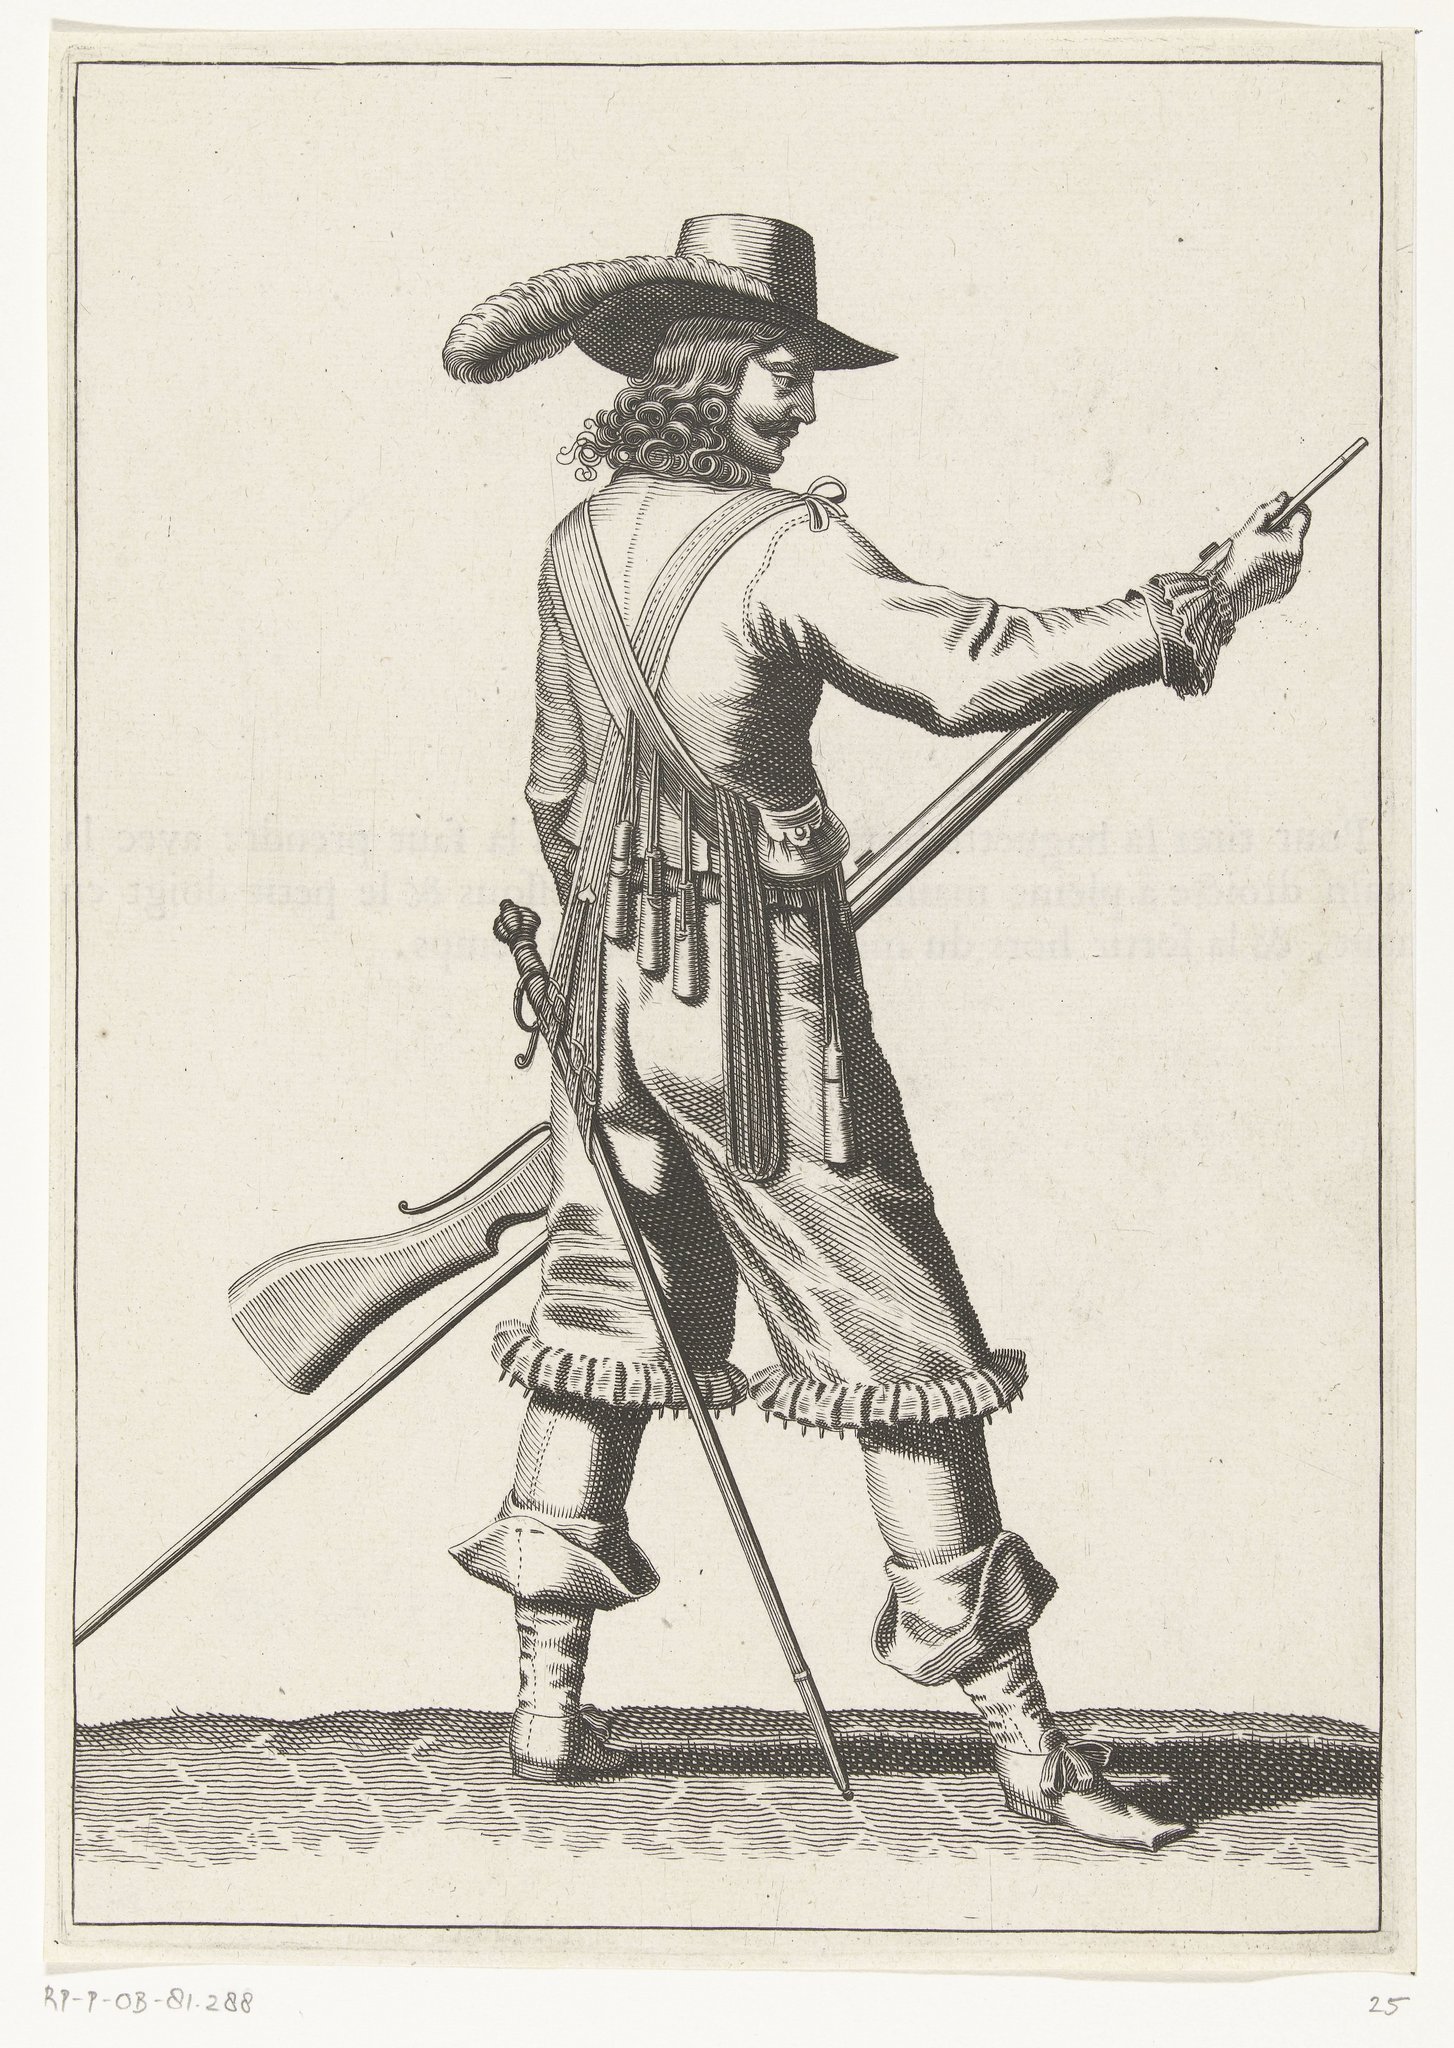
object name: print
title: Soldaat die zijn laadstok uit de houder onder de loop van zijn musket haalt, ca. 1645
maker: petrus rucholle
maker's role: print maker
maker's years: 1618-1647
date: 1645-1647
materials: paper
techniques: engraving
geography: southern netherlands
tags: handling of weapons ~ military training, weapons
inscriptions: annotation: ‘Tirer la baguette hors de mousquette en bon temps p. 61’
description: Een soldaat, ten voeten uit, naar rechts, op de rug gezien, die met zijn linkerhand bij zijn linkerdijbeen een musket (een bepaald type vuurwapen) vasthoudt en met zijn rechterhand de laadstok uit de houder onder de loop haalt. In zijn linkerhand behalve het musket ook een brandende lont; aan zijn linkerpols een furket (musketvork). Bedrukt op achterzijde met tekst in het Frans. Vrije kopie naar plaat 25 in de instructies voor het hanteren van het musket in de Wapenhandelinghe van J. de Gheyn. Krijgswezen rond 1600.